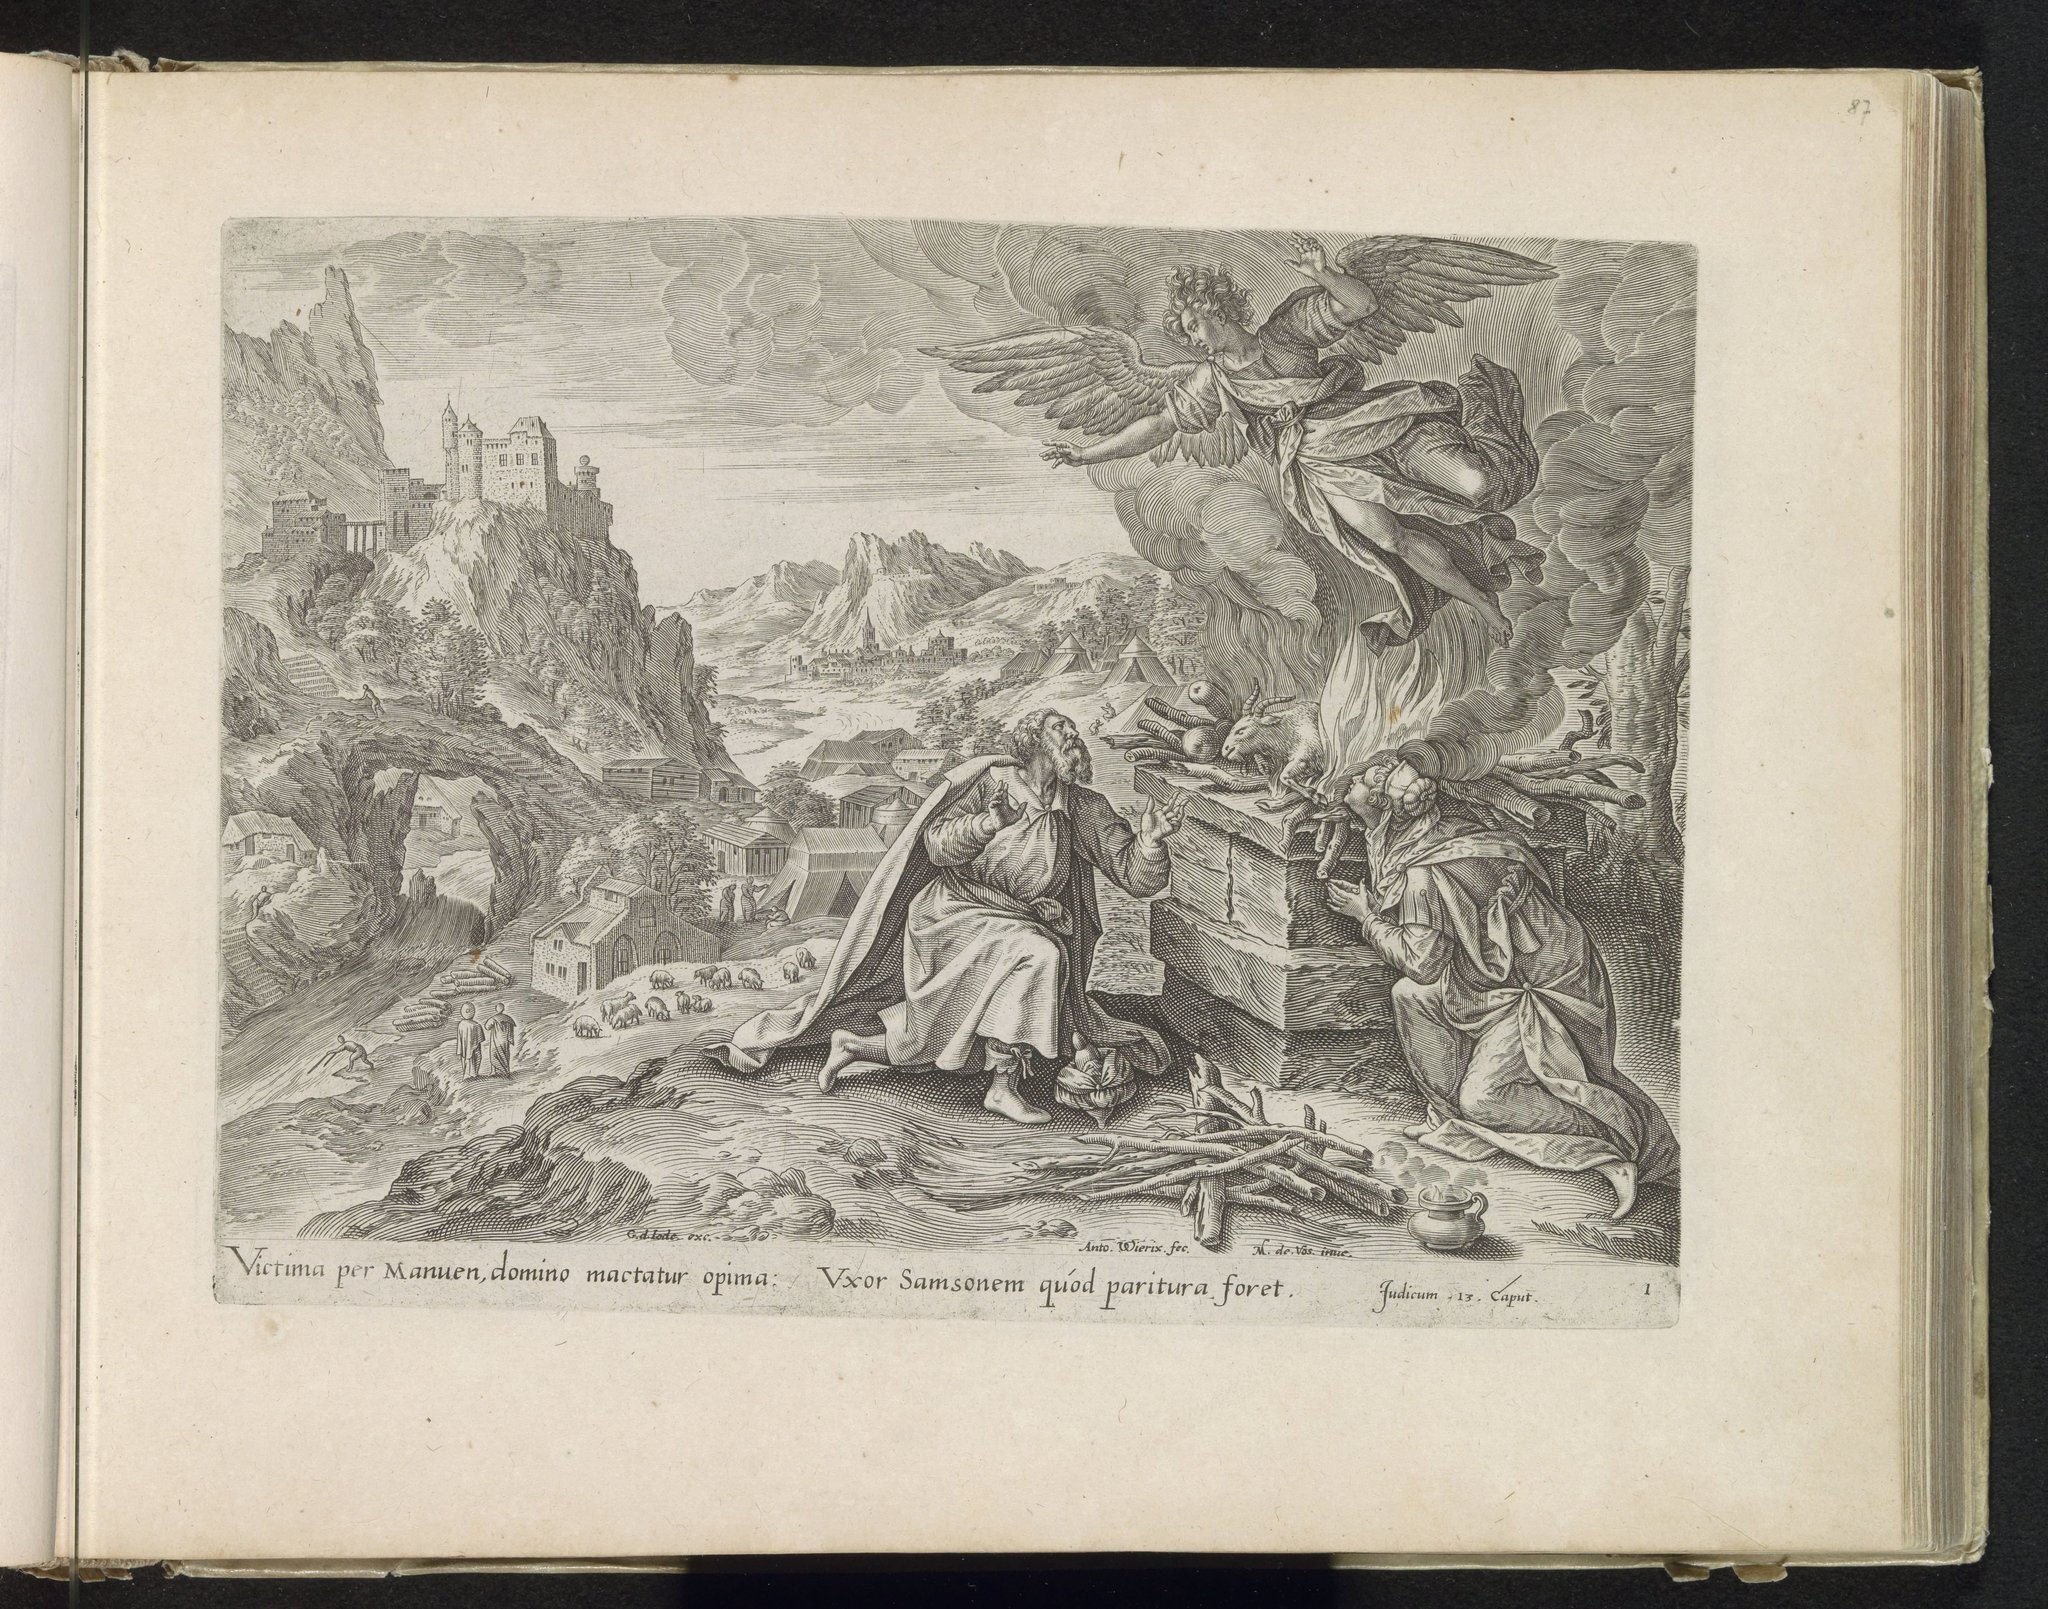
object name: print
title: Thesaurus sacrarum historiaru[m] veteris testame[n]ti, elega[n]tissimis imaginibus expressu[m] excelle[n]tissimoru[m] in hac arte viroru[m] opera: nu[n]c primu[m] in luce[m] editus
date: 1585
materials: paper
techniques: engraving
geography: antwerp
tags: manoah's sacrifice; the angel ascends in the flames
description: Manoach en zijn vrouw werpen zich neer bij het altaar, waar Manoach een geit offerde. De aartsengel Gabriël, die Manoach en zijn vrouw de geboorte van een zoon aankondigde, vaart in de vlammen van het offer ten hemel. Onder de voorstelling een verwijzing in het Latijn naar de Bijbeltekst in Ri. 13. Deze prent maakt deel uit van een album.